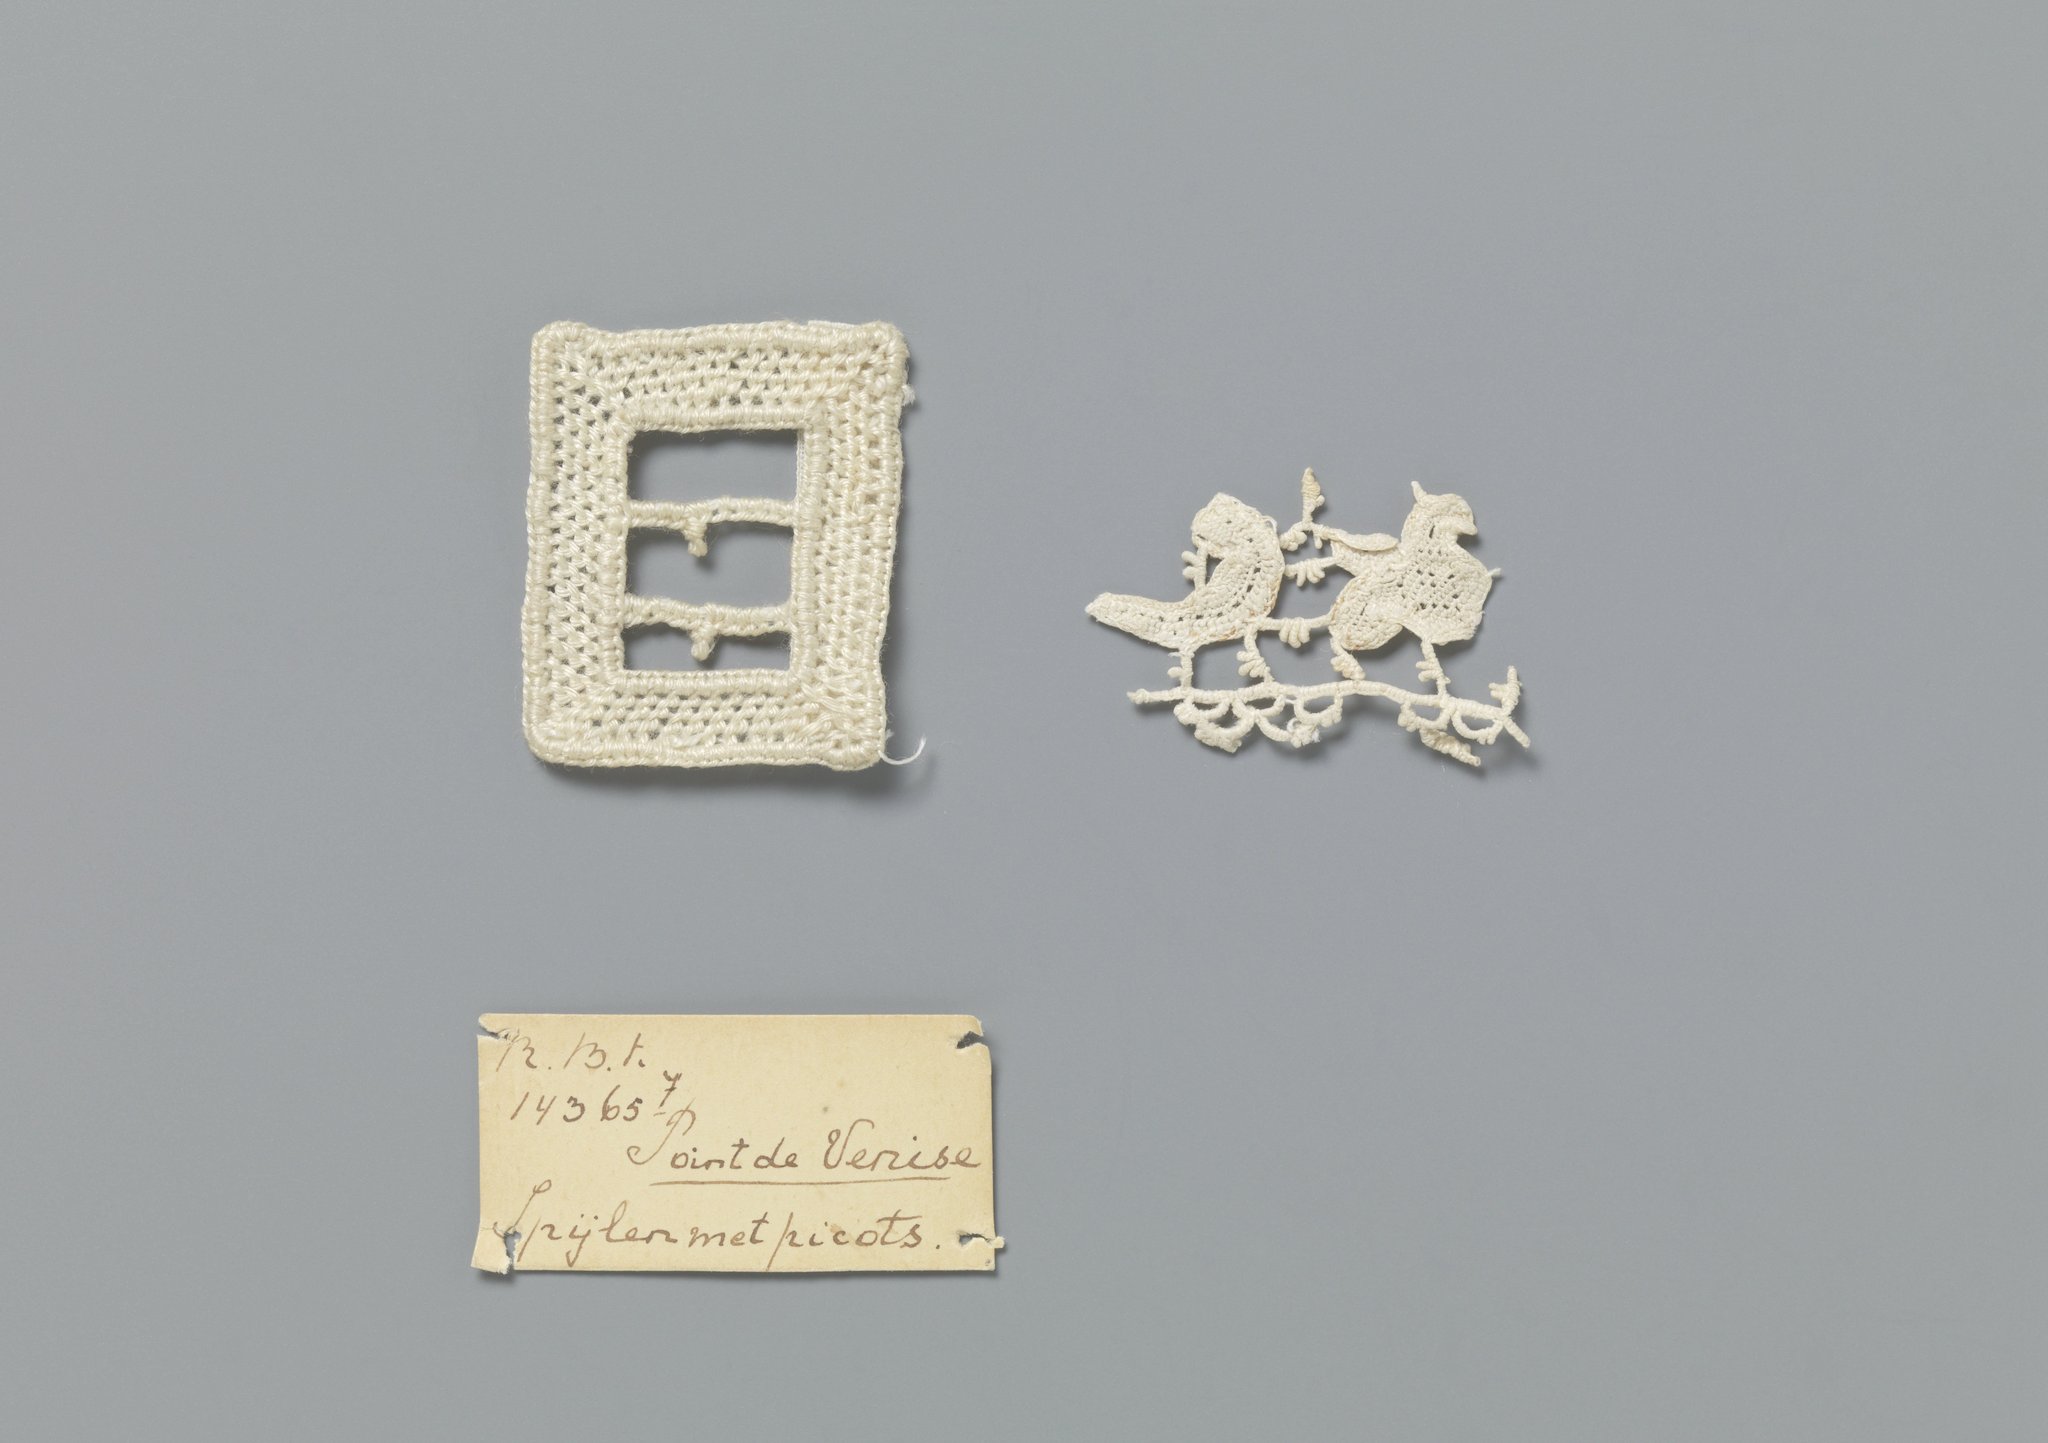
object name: sample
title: Staal naaldkant met grove draad gemaakt als voorbeeld van spijlen met picots zoals toegepast in Venetiaanse naaldkant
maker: Anonymous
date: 1925-1929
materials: linen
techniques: needlepoint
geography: netherlands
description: Staal naturelkleurige naaldkant. Rechthoekig model. In een rechthoekig kader zijn twee parallel lopende spijlen gemaakt, met festonsteken over een spandraad en aan elke spijl één picot. Het kader bestaat ook uit festonsteken, waarbij de steken bij de binnen- en buitenrand om een draad gewerkt zijn. De binnen- en buitenrand vormen zodoende lichte reliëfcontourlijnen. De staal is met grove draad gemaakt als voorbeeld van spijlen met picots zoals toegepast in Venetiaanse naaldkant. Bij de staal hoort een fragment kant waarin deze techniek is toegepast.